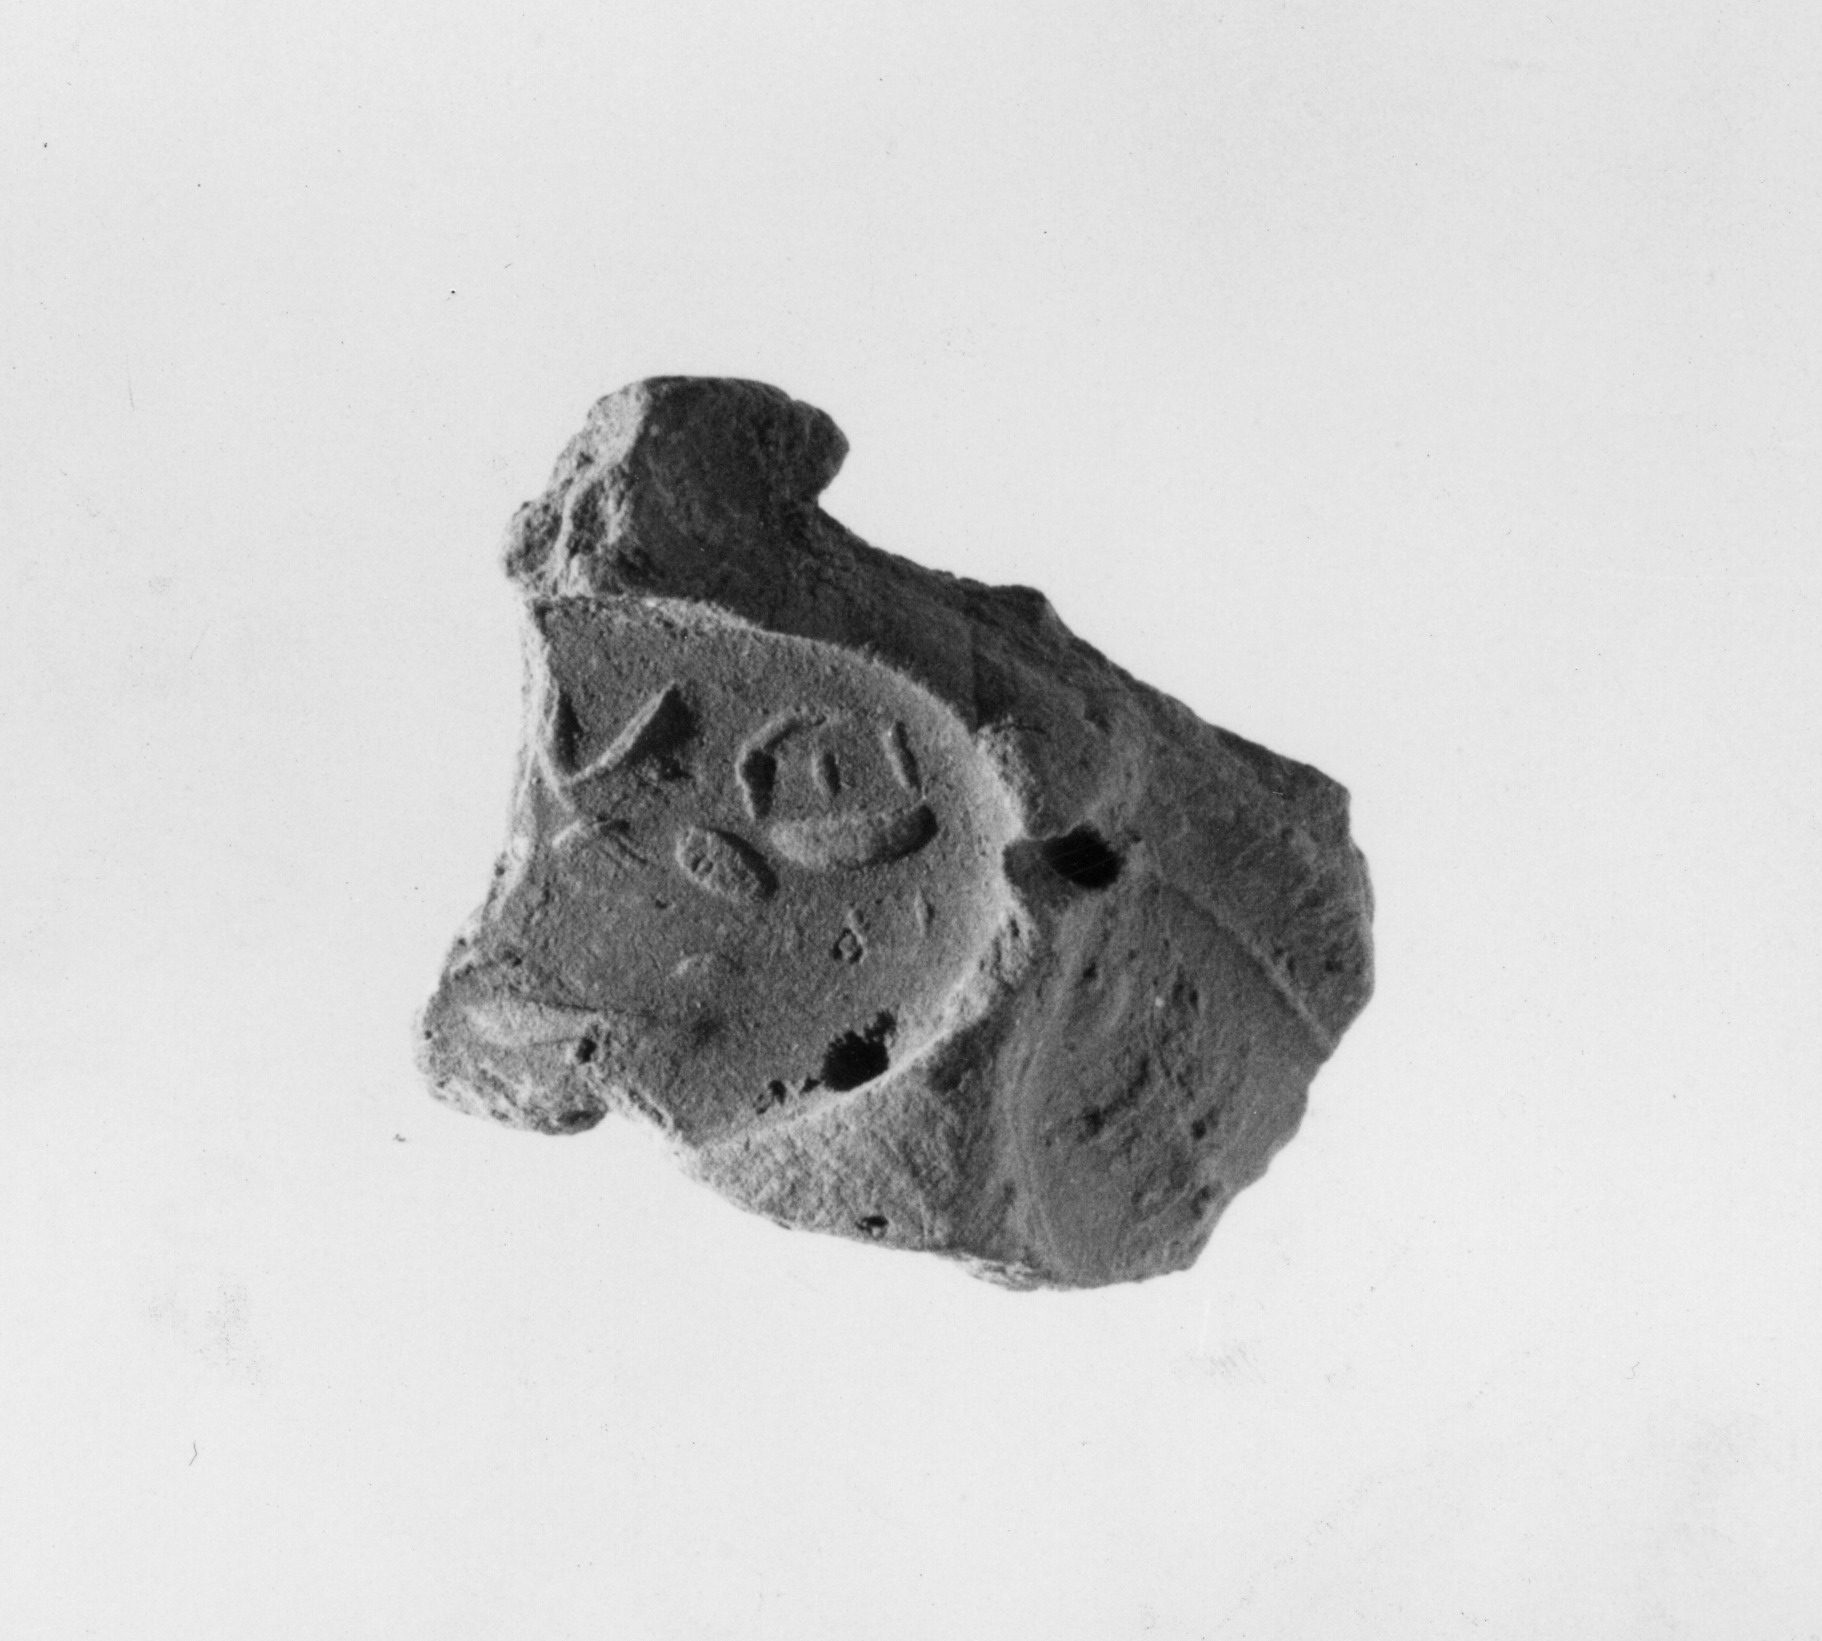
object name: sealing, bee, heb sed, djed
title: Document Sealing With Multiple Seal Impressions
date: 1390-1352 BCE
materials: mud